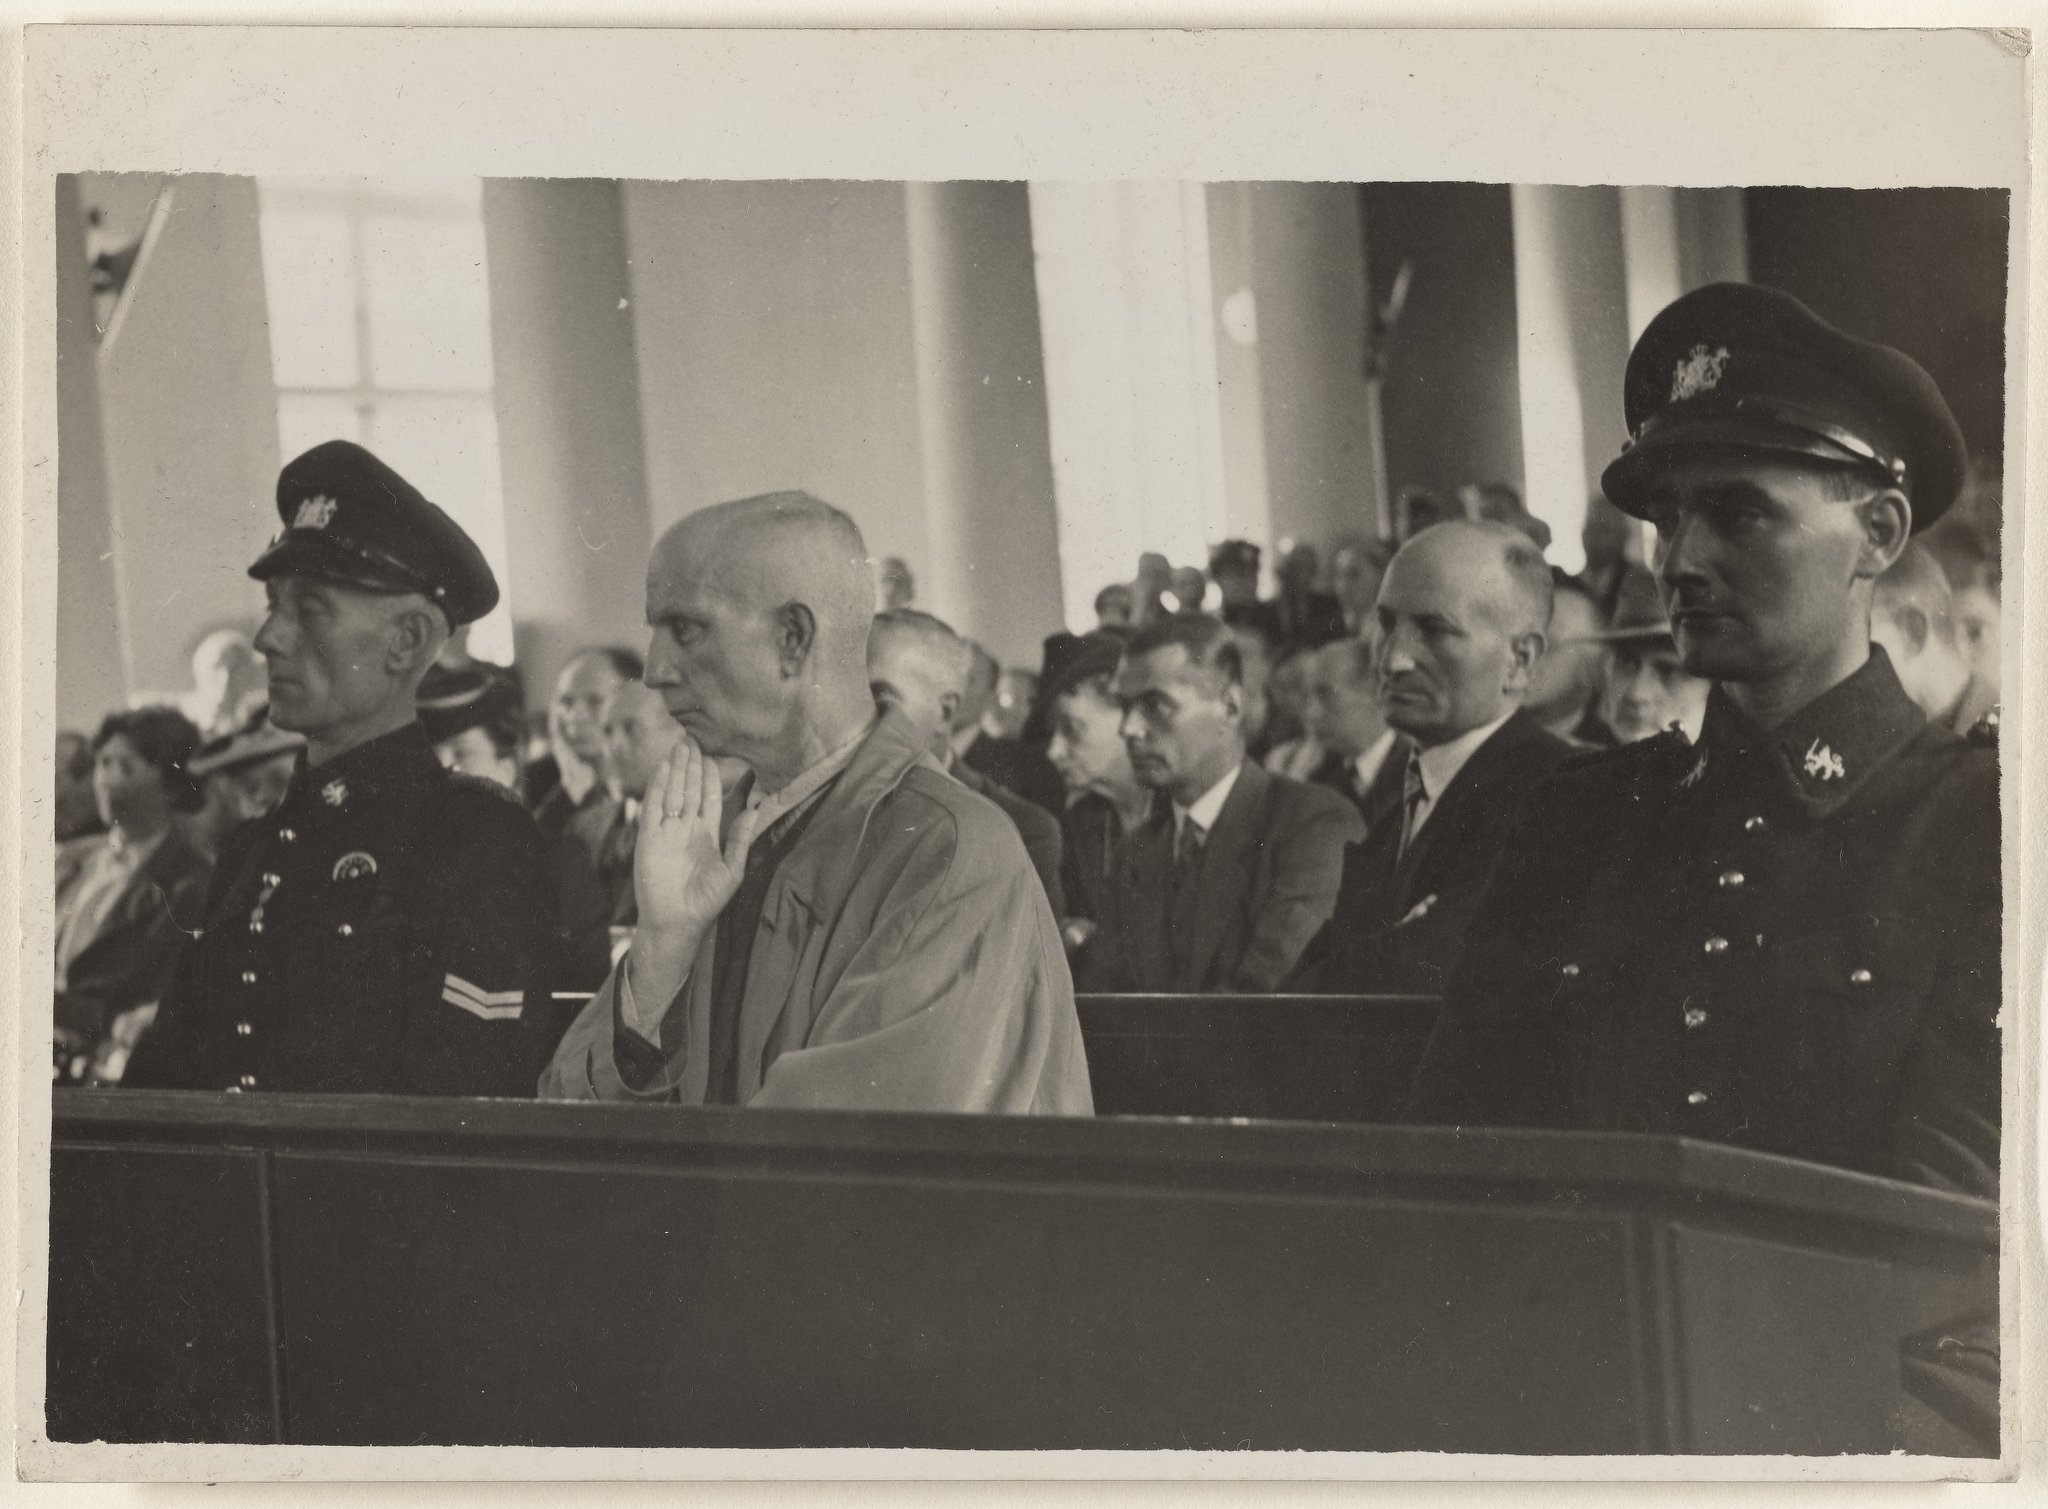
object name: photograph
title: Proces Max Blokzijl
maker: Anonymous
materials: photographic support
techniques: photography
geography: the hague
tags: max blokzijl, the hague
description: Het proces vond plaats in het paleis aan de Kneuterdijk. Blokzijl werd, als eerste collaborateur, ter dood veroordeeld en op 16 maart 1946 gefusilleerd. [Baruch, Jet, 2006].